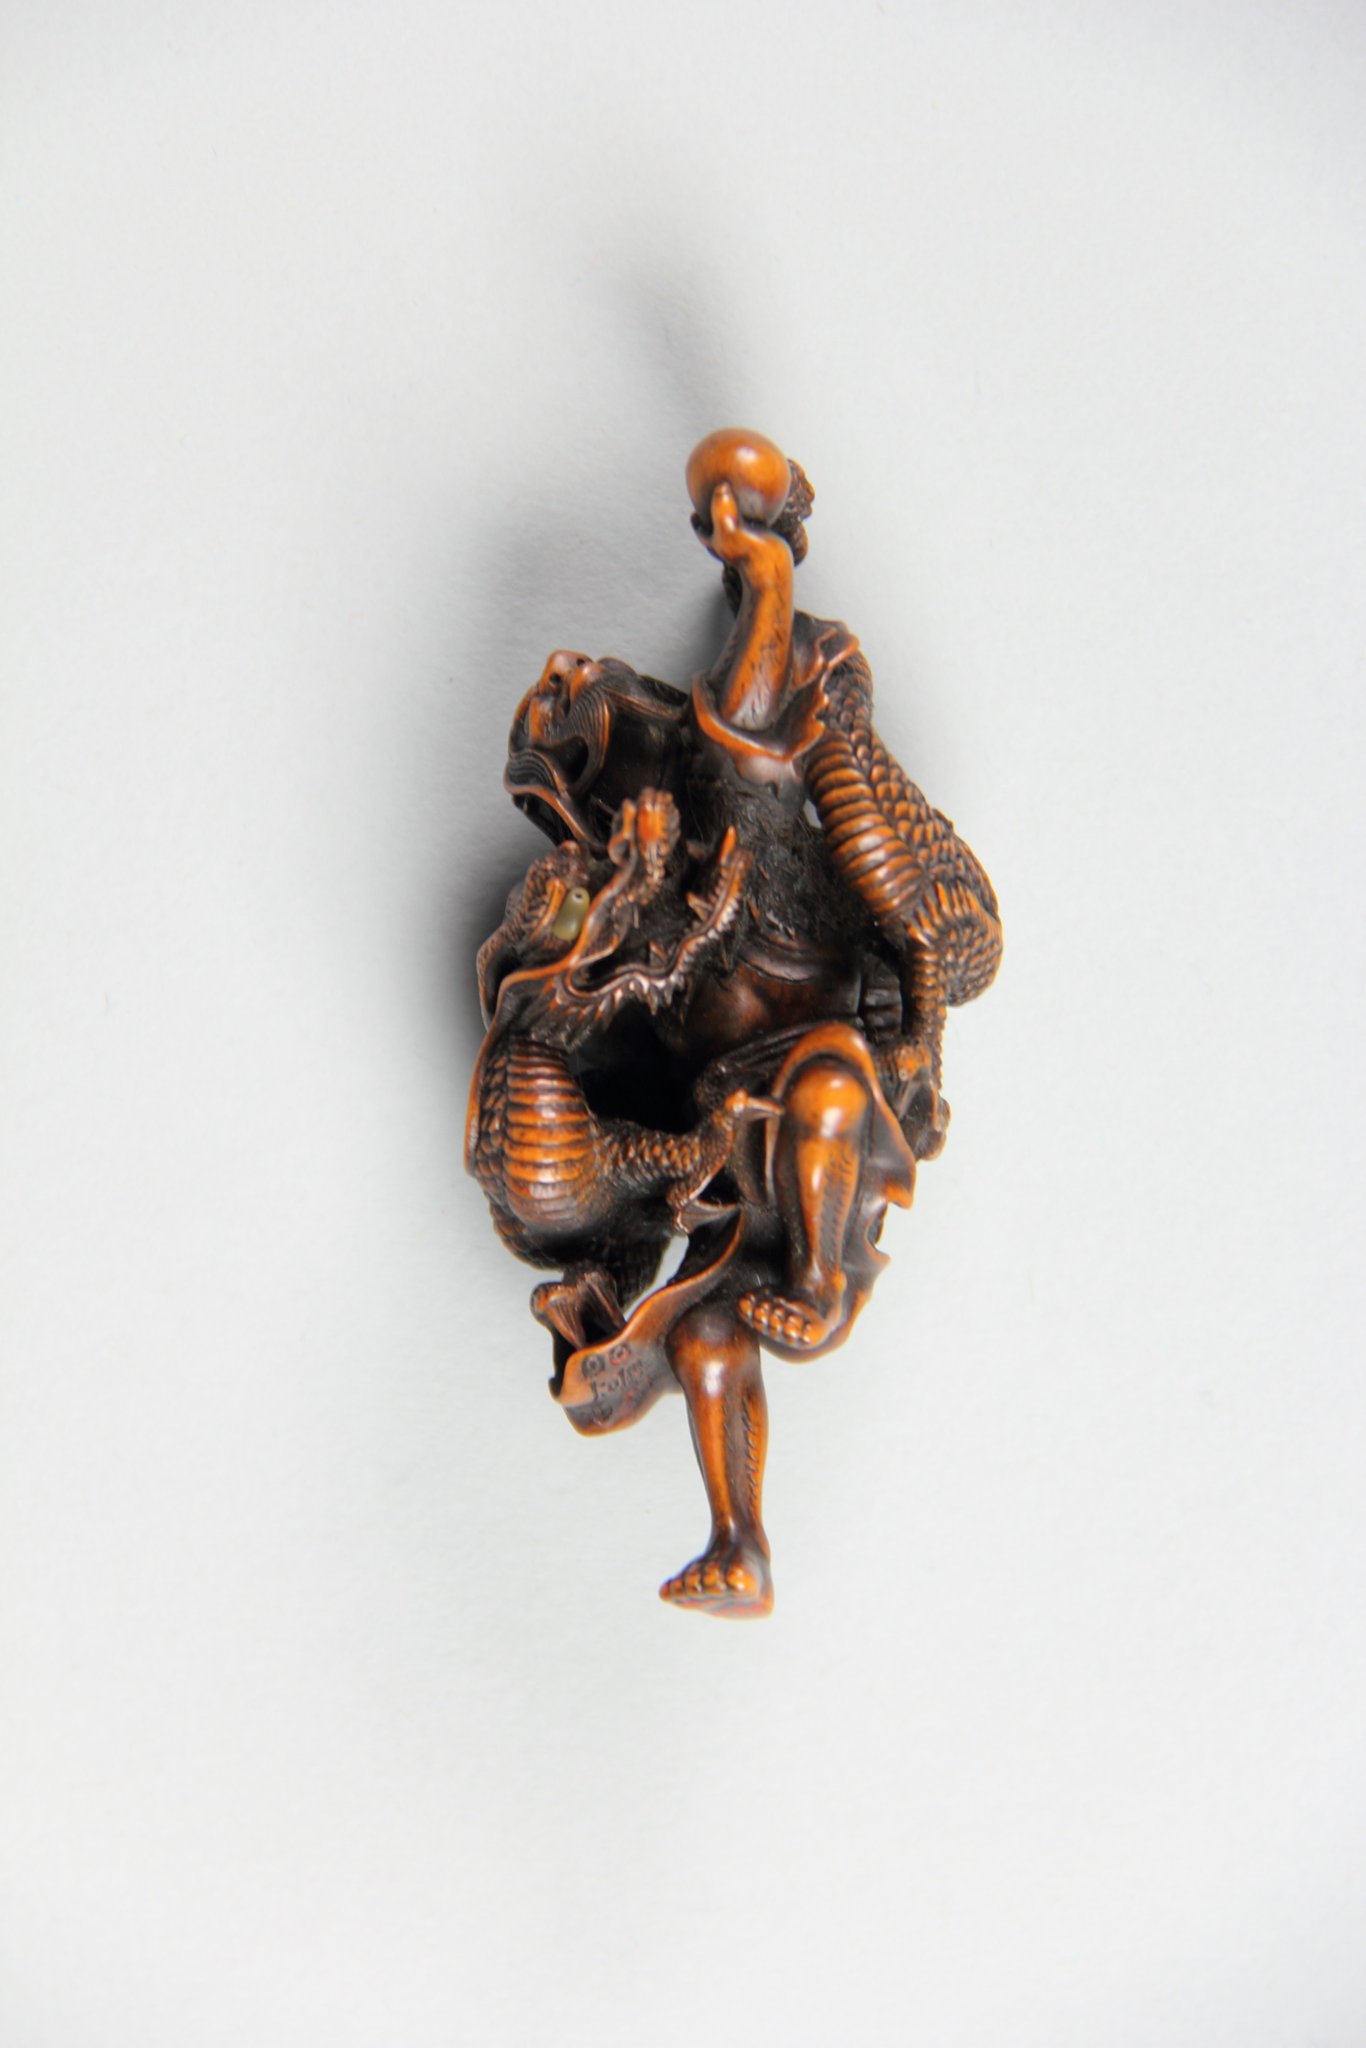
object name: netsuke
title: Netsuke of Dragon Coiled around the Body of a Man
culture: japanese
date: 1801-1900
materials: glass, wood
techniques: inlay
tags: men,dragons